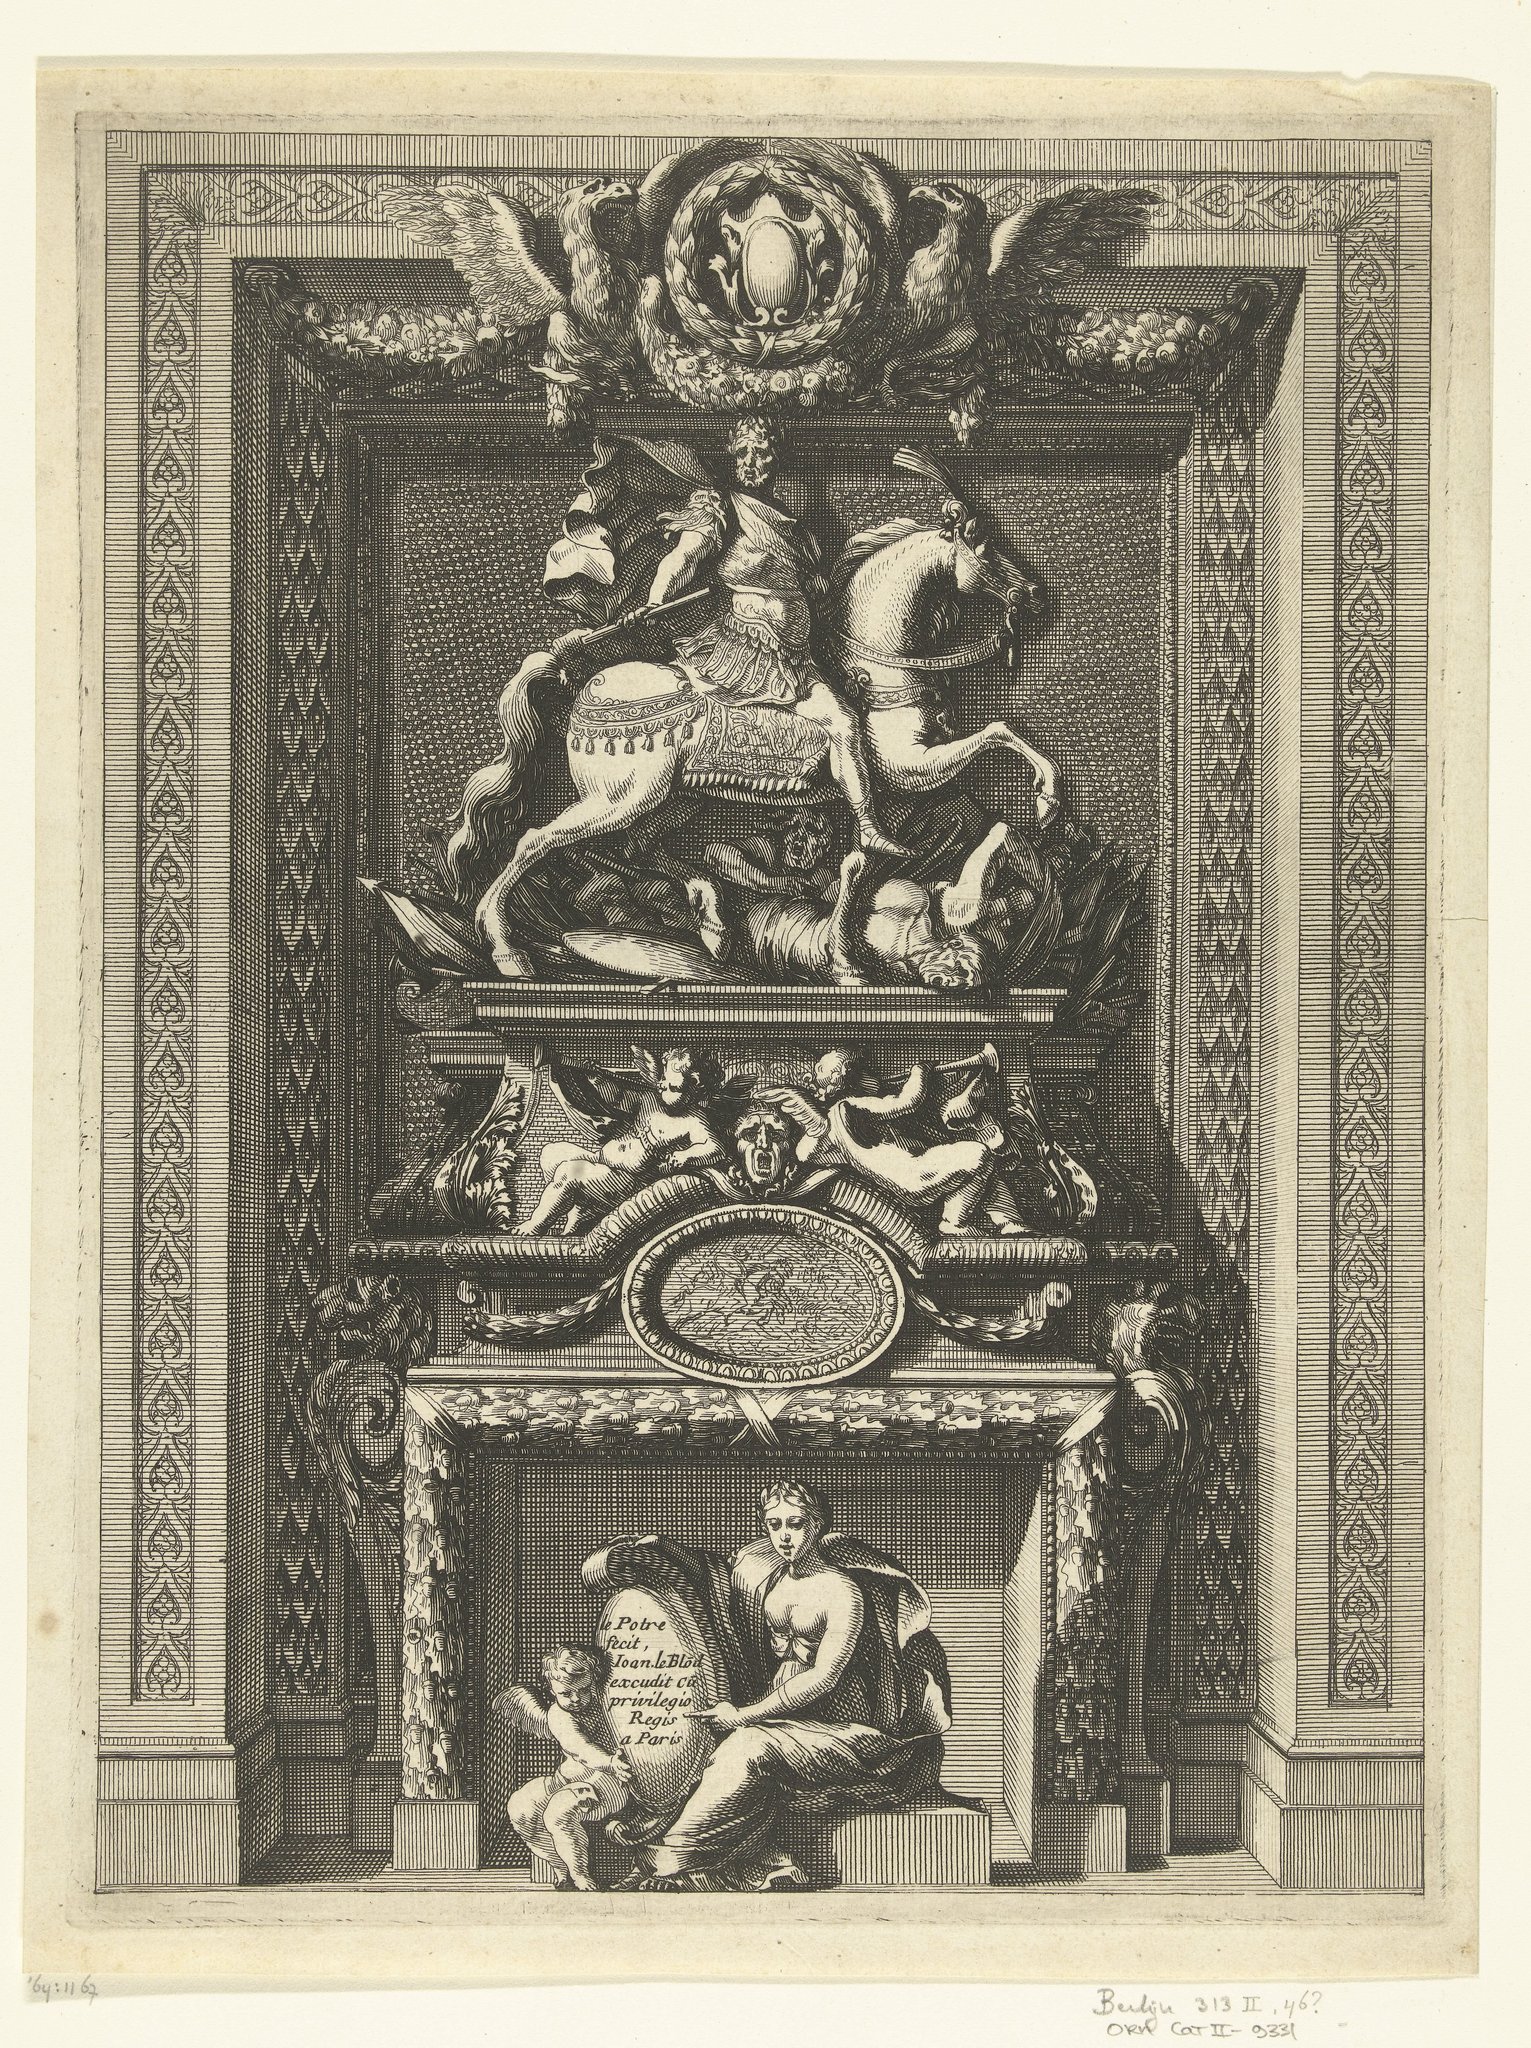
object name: ornament print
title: Onderboezems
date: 1660-1666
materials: paper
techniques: etching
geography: france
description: Bovenaan een keizer te paard met daaronder een wapentrofee en gevallen soldaten. Uit serie van 6 bladen.